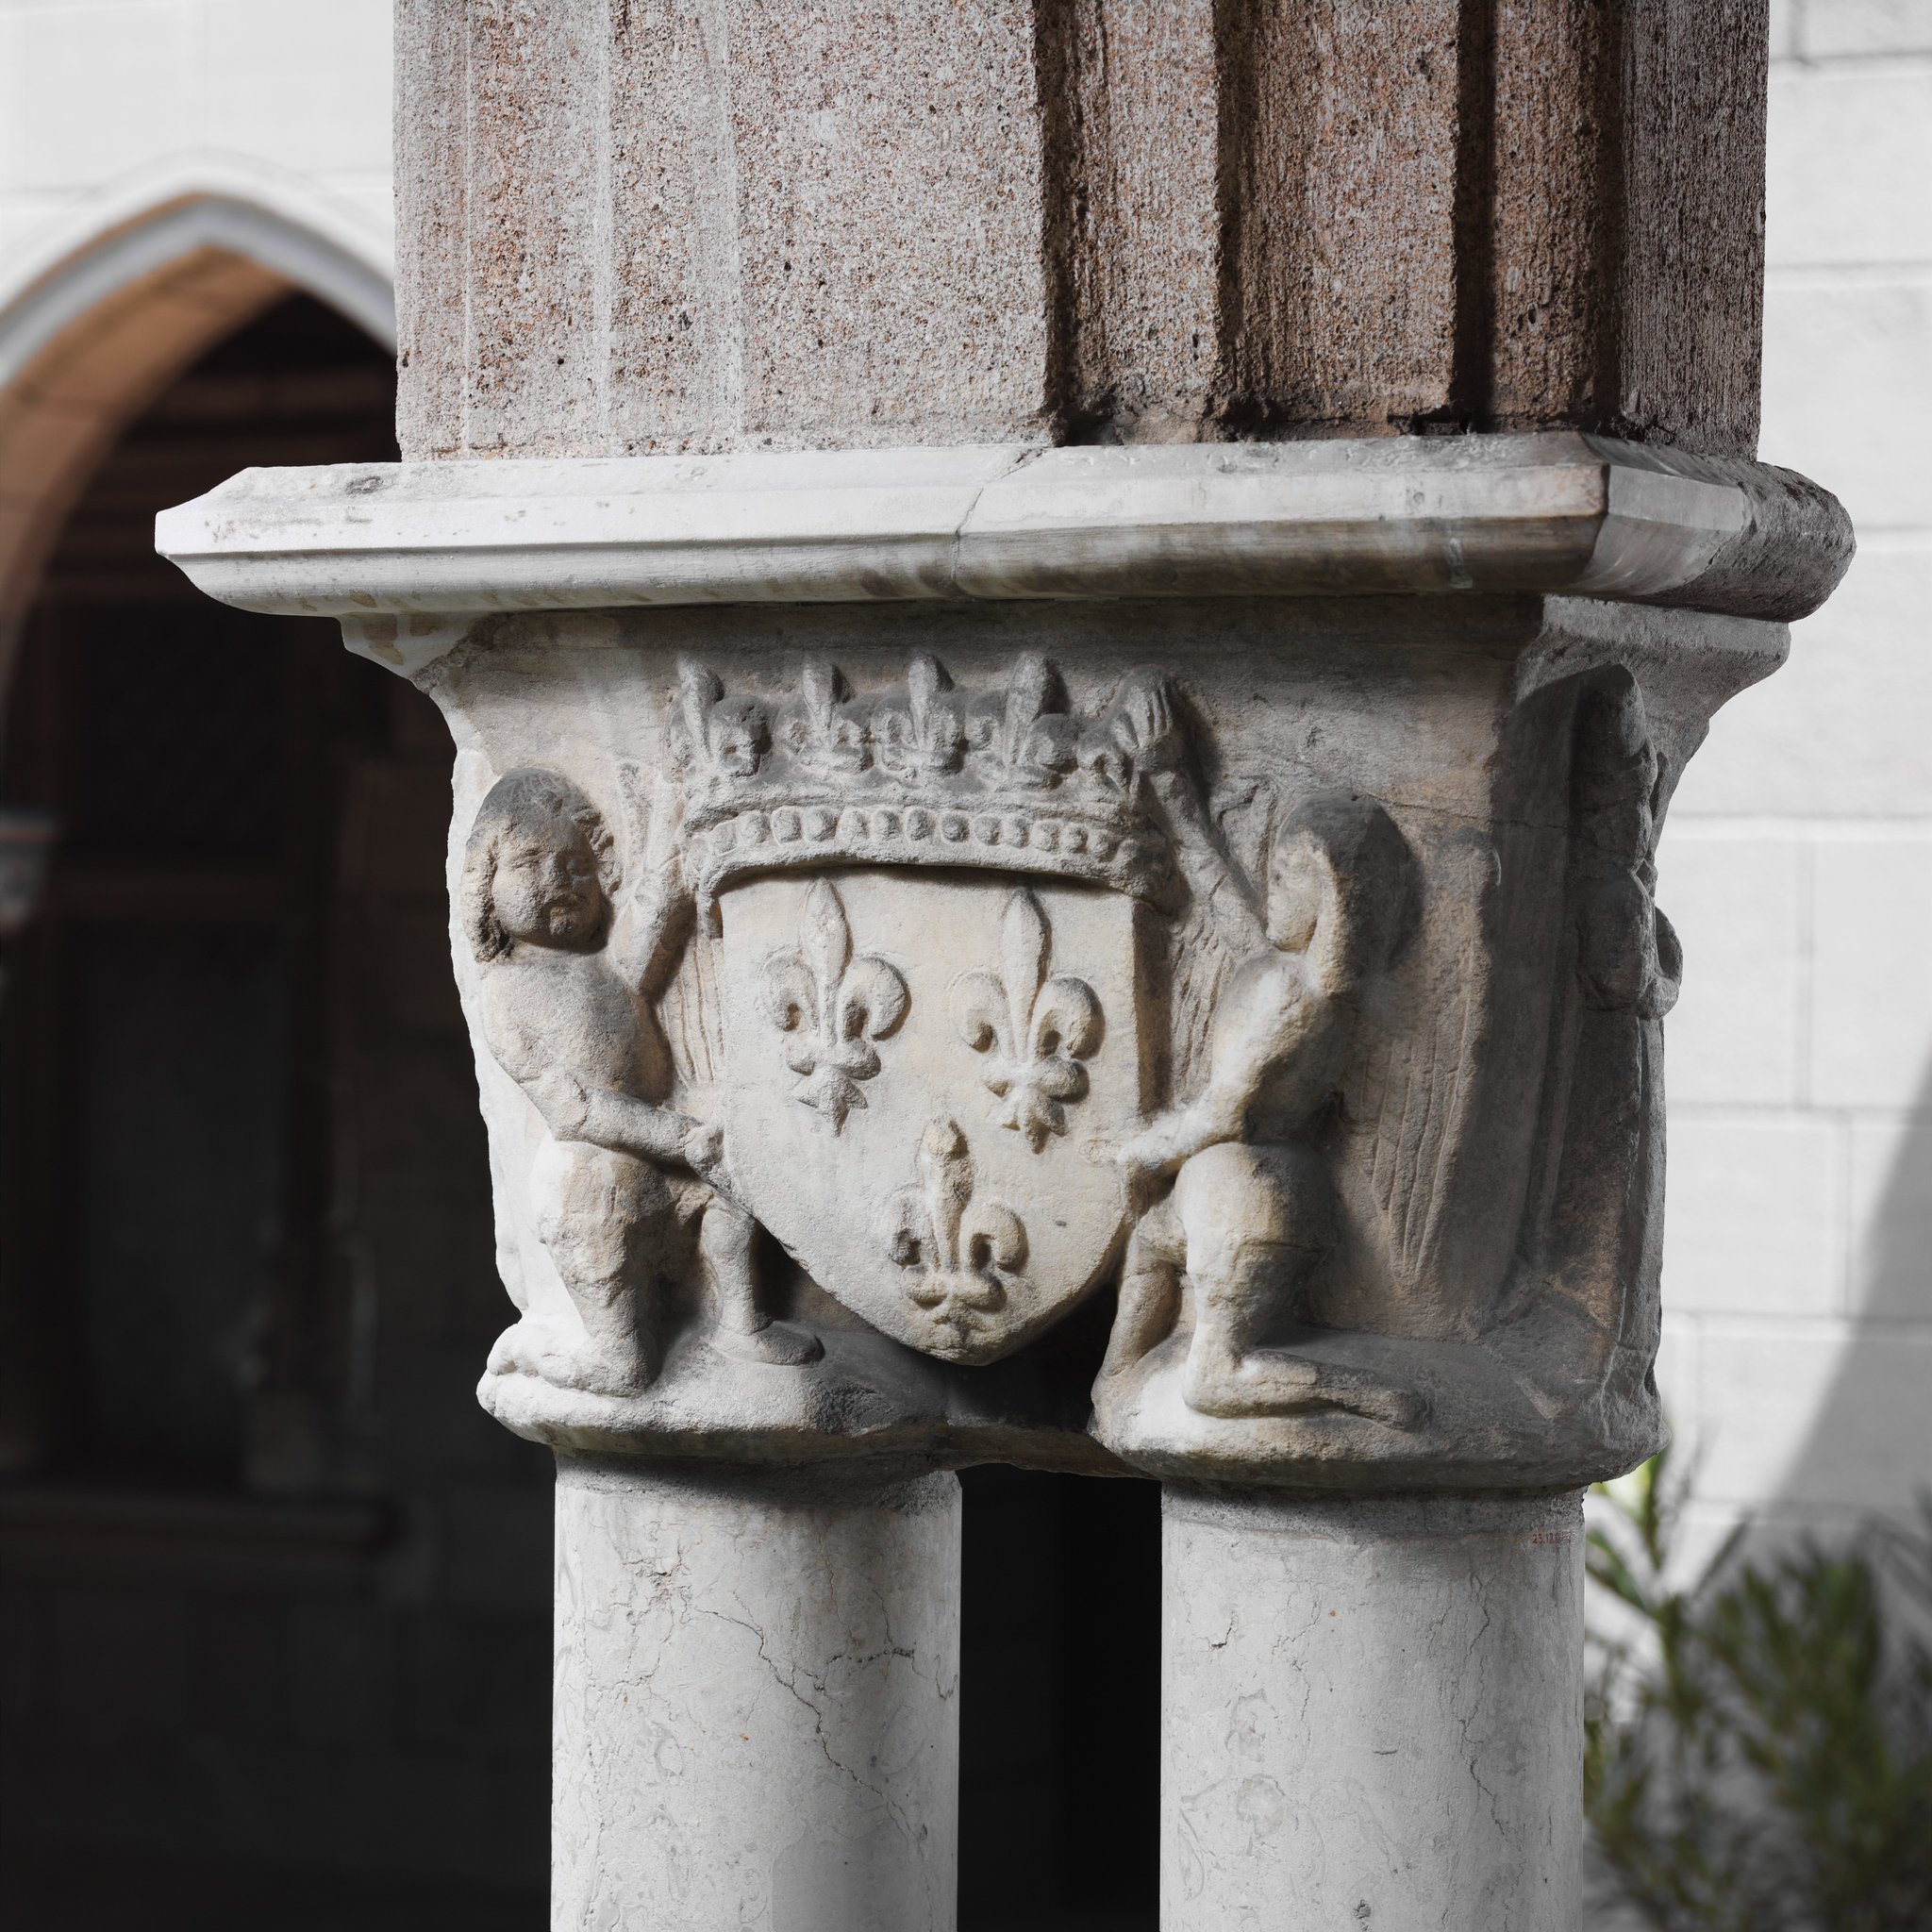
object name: capital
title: Double Capital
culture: french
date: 1467-1500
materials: marble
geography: france